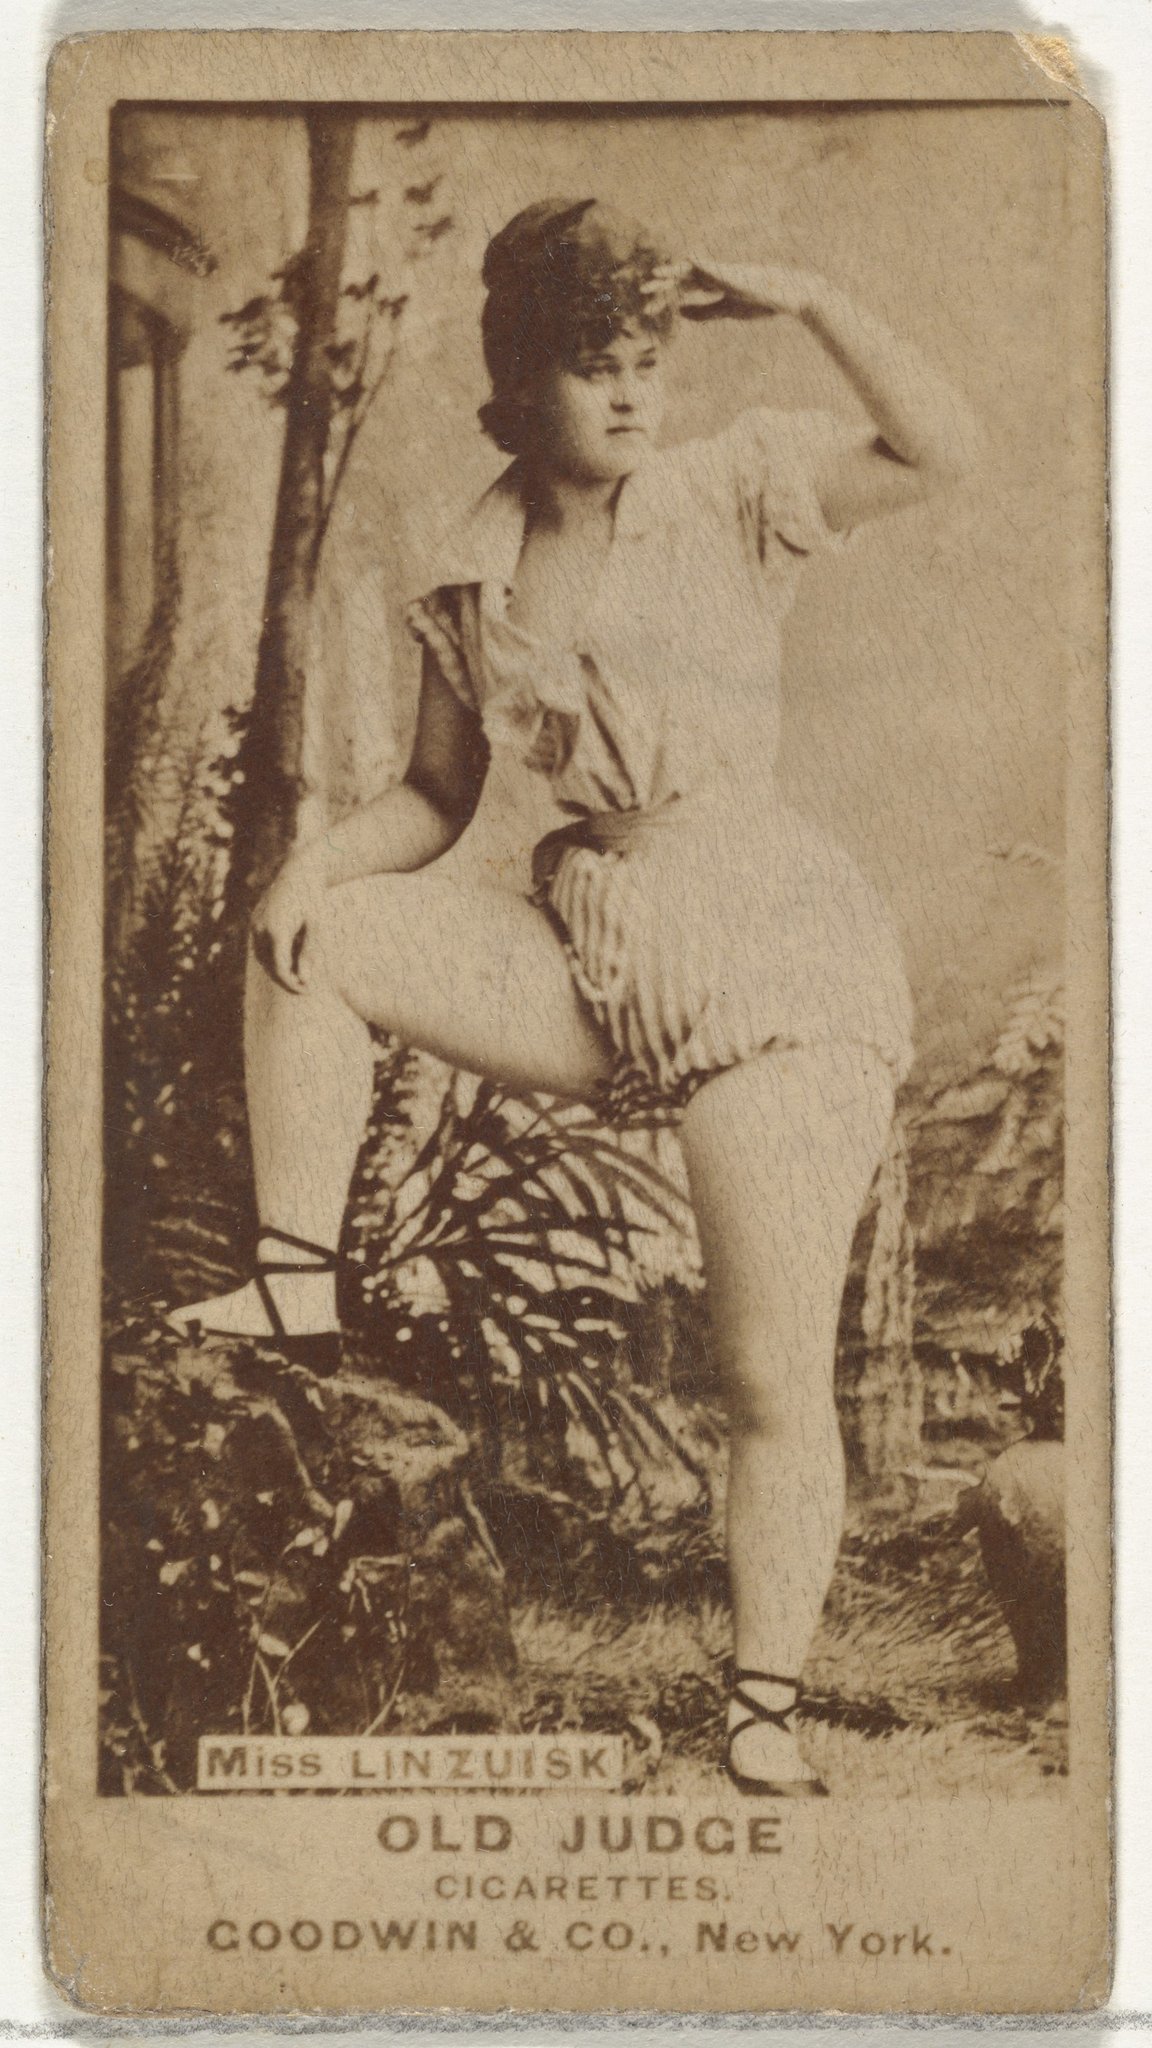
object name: photograph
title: Miss Linzuisk, from the Actors and Actresses series (N171) for Old Judge Cigarettes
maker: goodwin & company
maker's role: publisher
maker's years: 1850-1950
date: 1886-1890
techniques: albumen silver print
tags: portraits,women,actresses